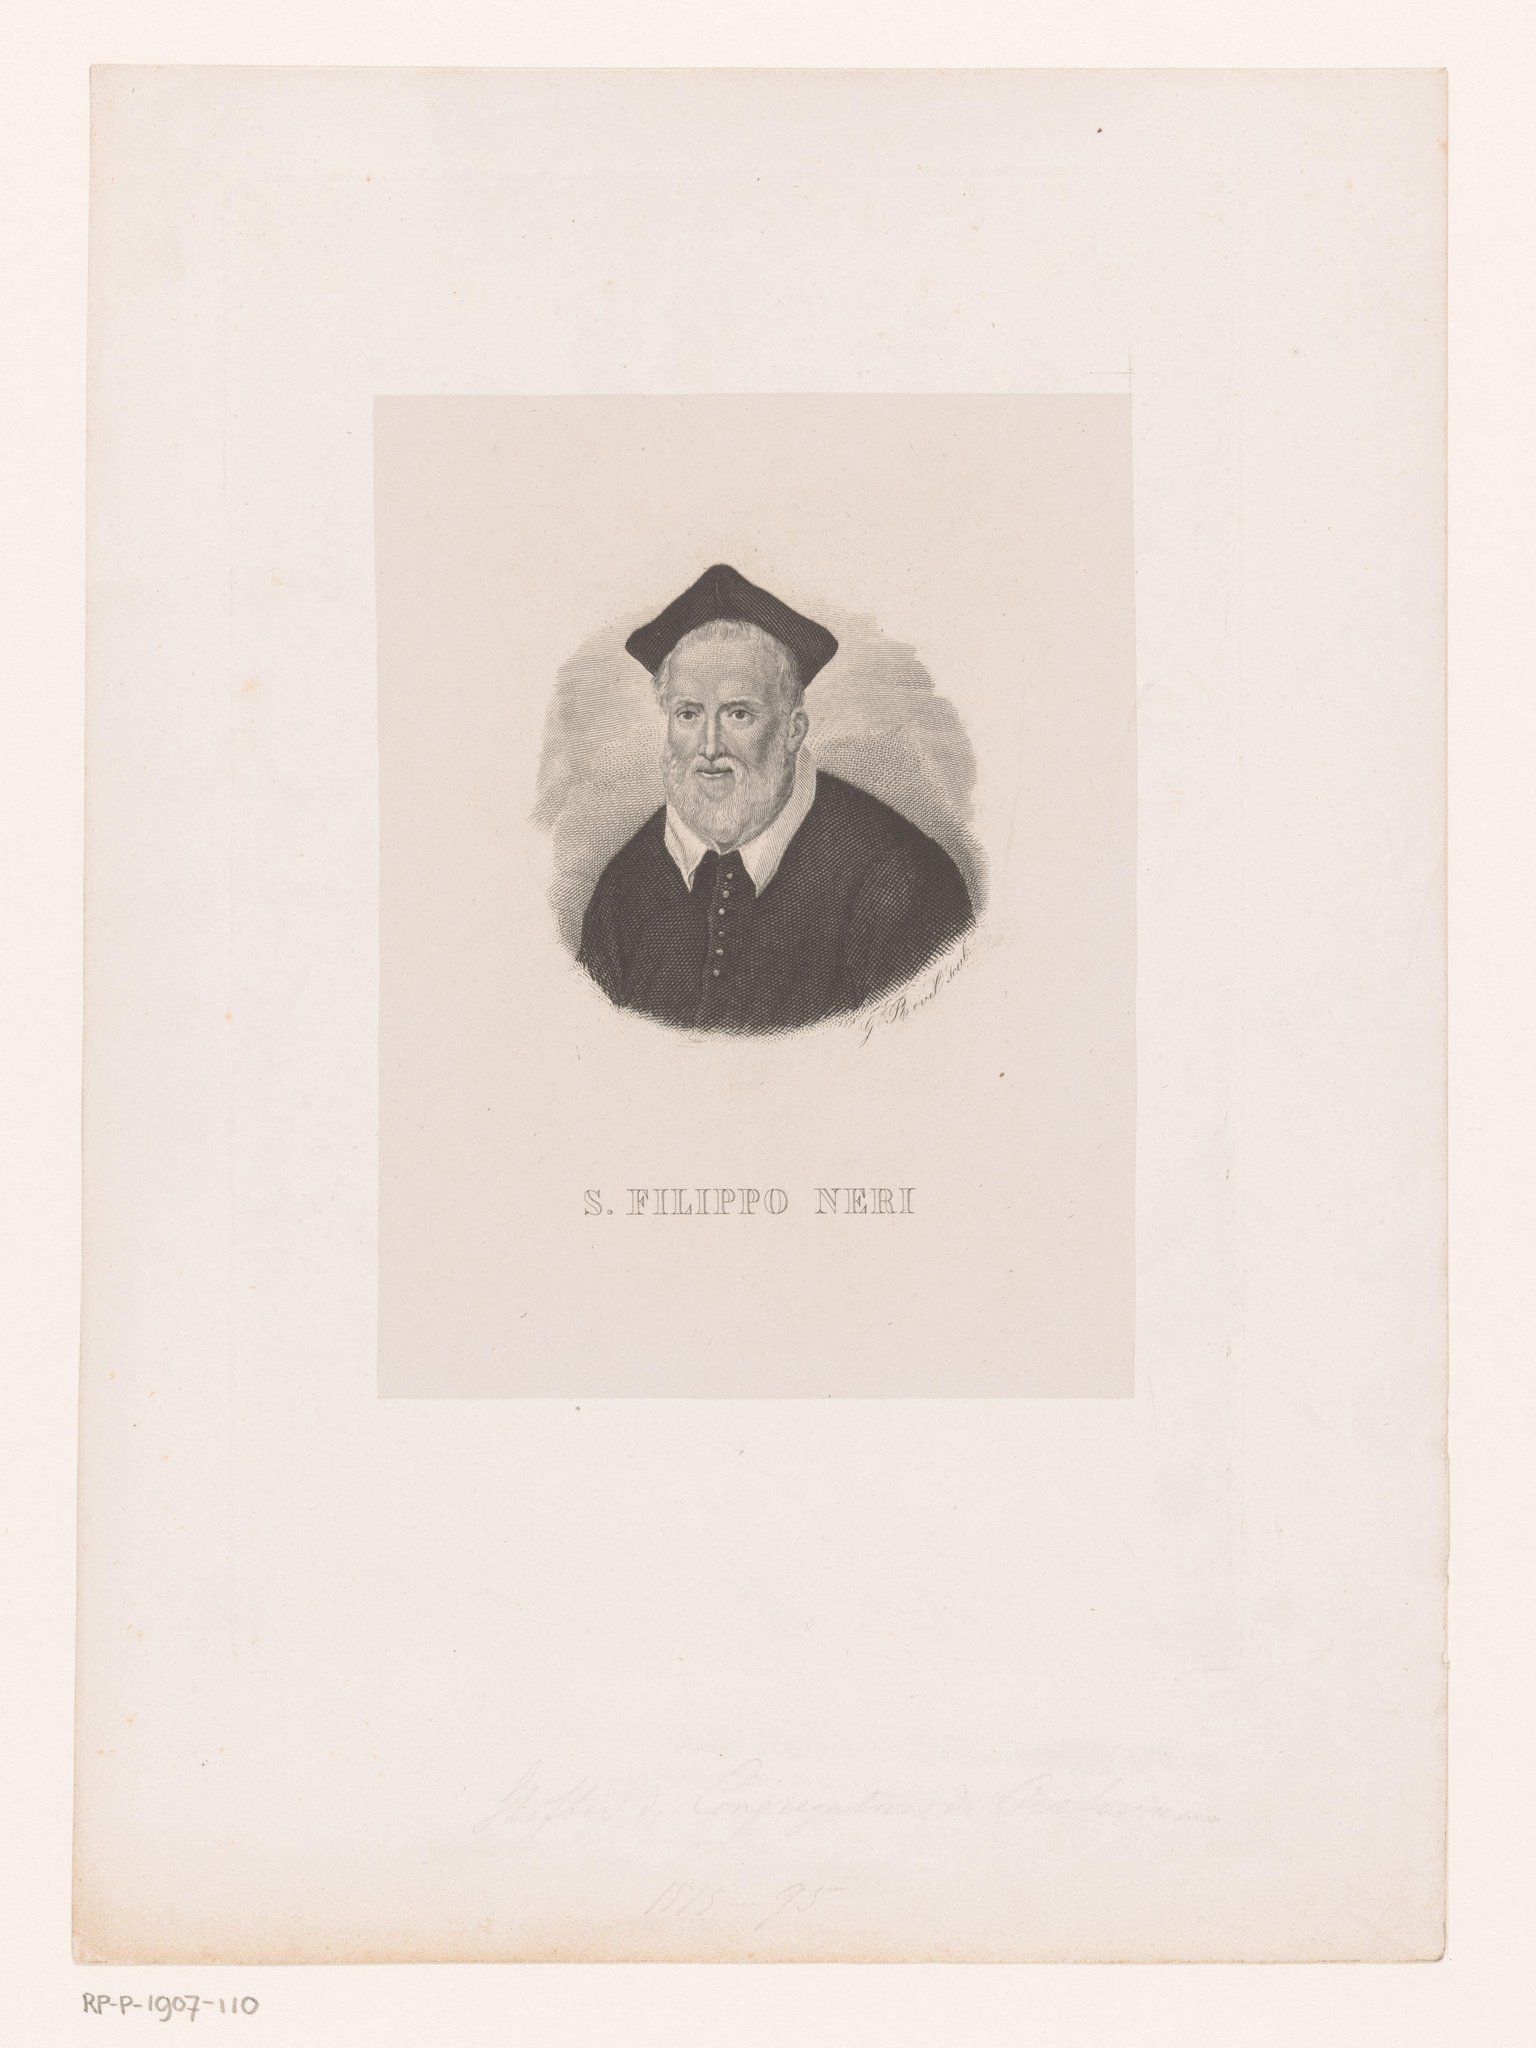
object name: print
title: Portret van Filippo Neri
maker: g. revel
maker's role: print maker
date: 1800-1900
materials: paper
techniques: engraving, etching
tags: clergyman, priest (roman catholic), historical persons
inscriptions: collector's mark: Lugt 2228